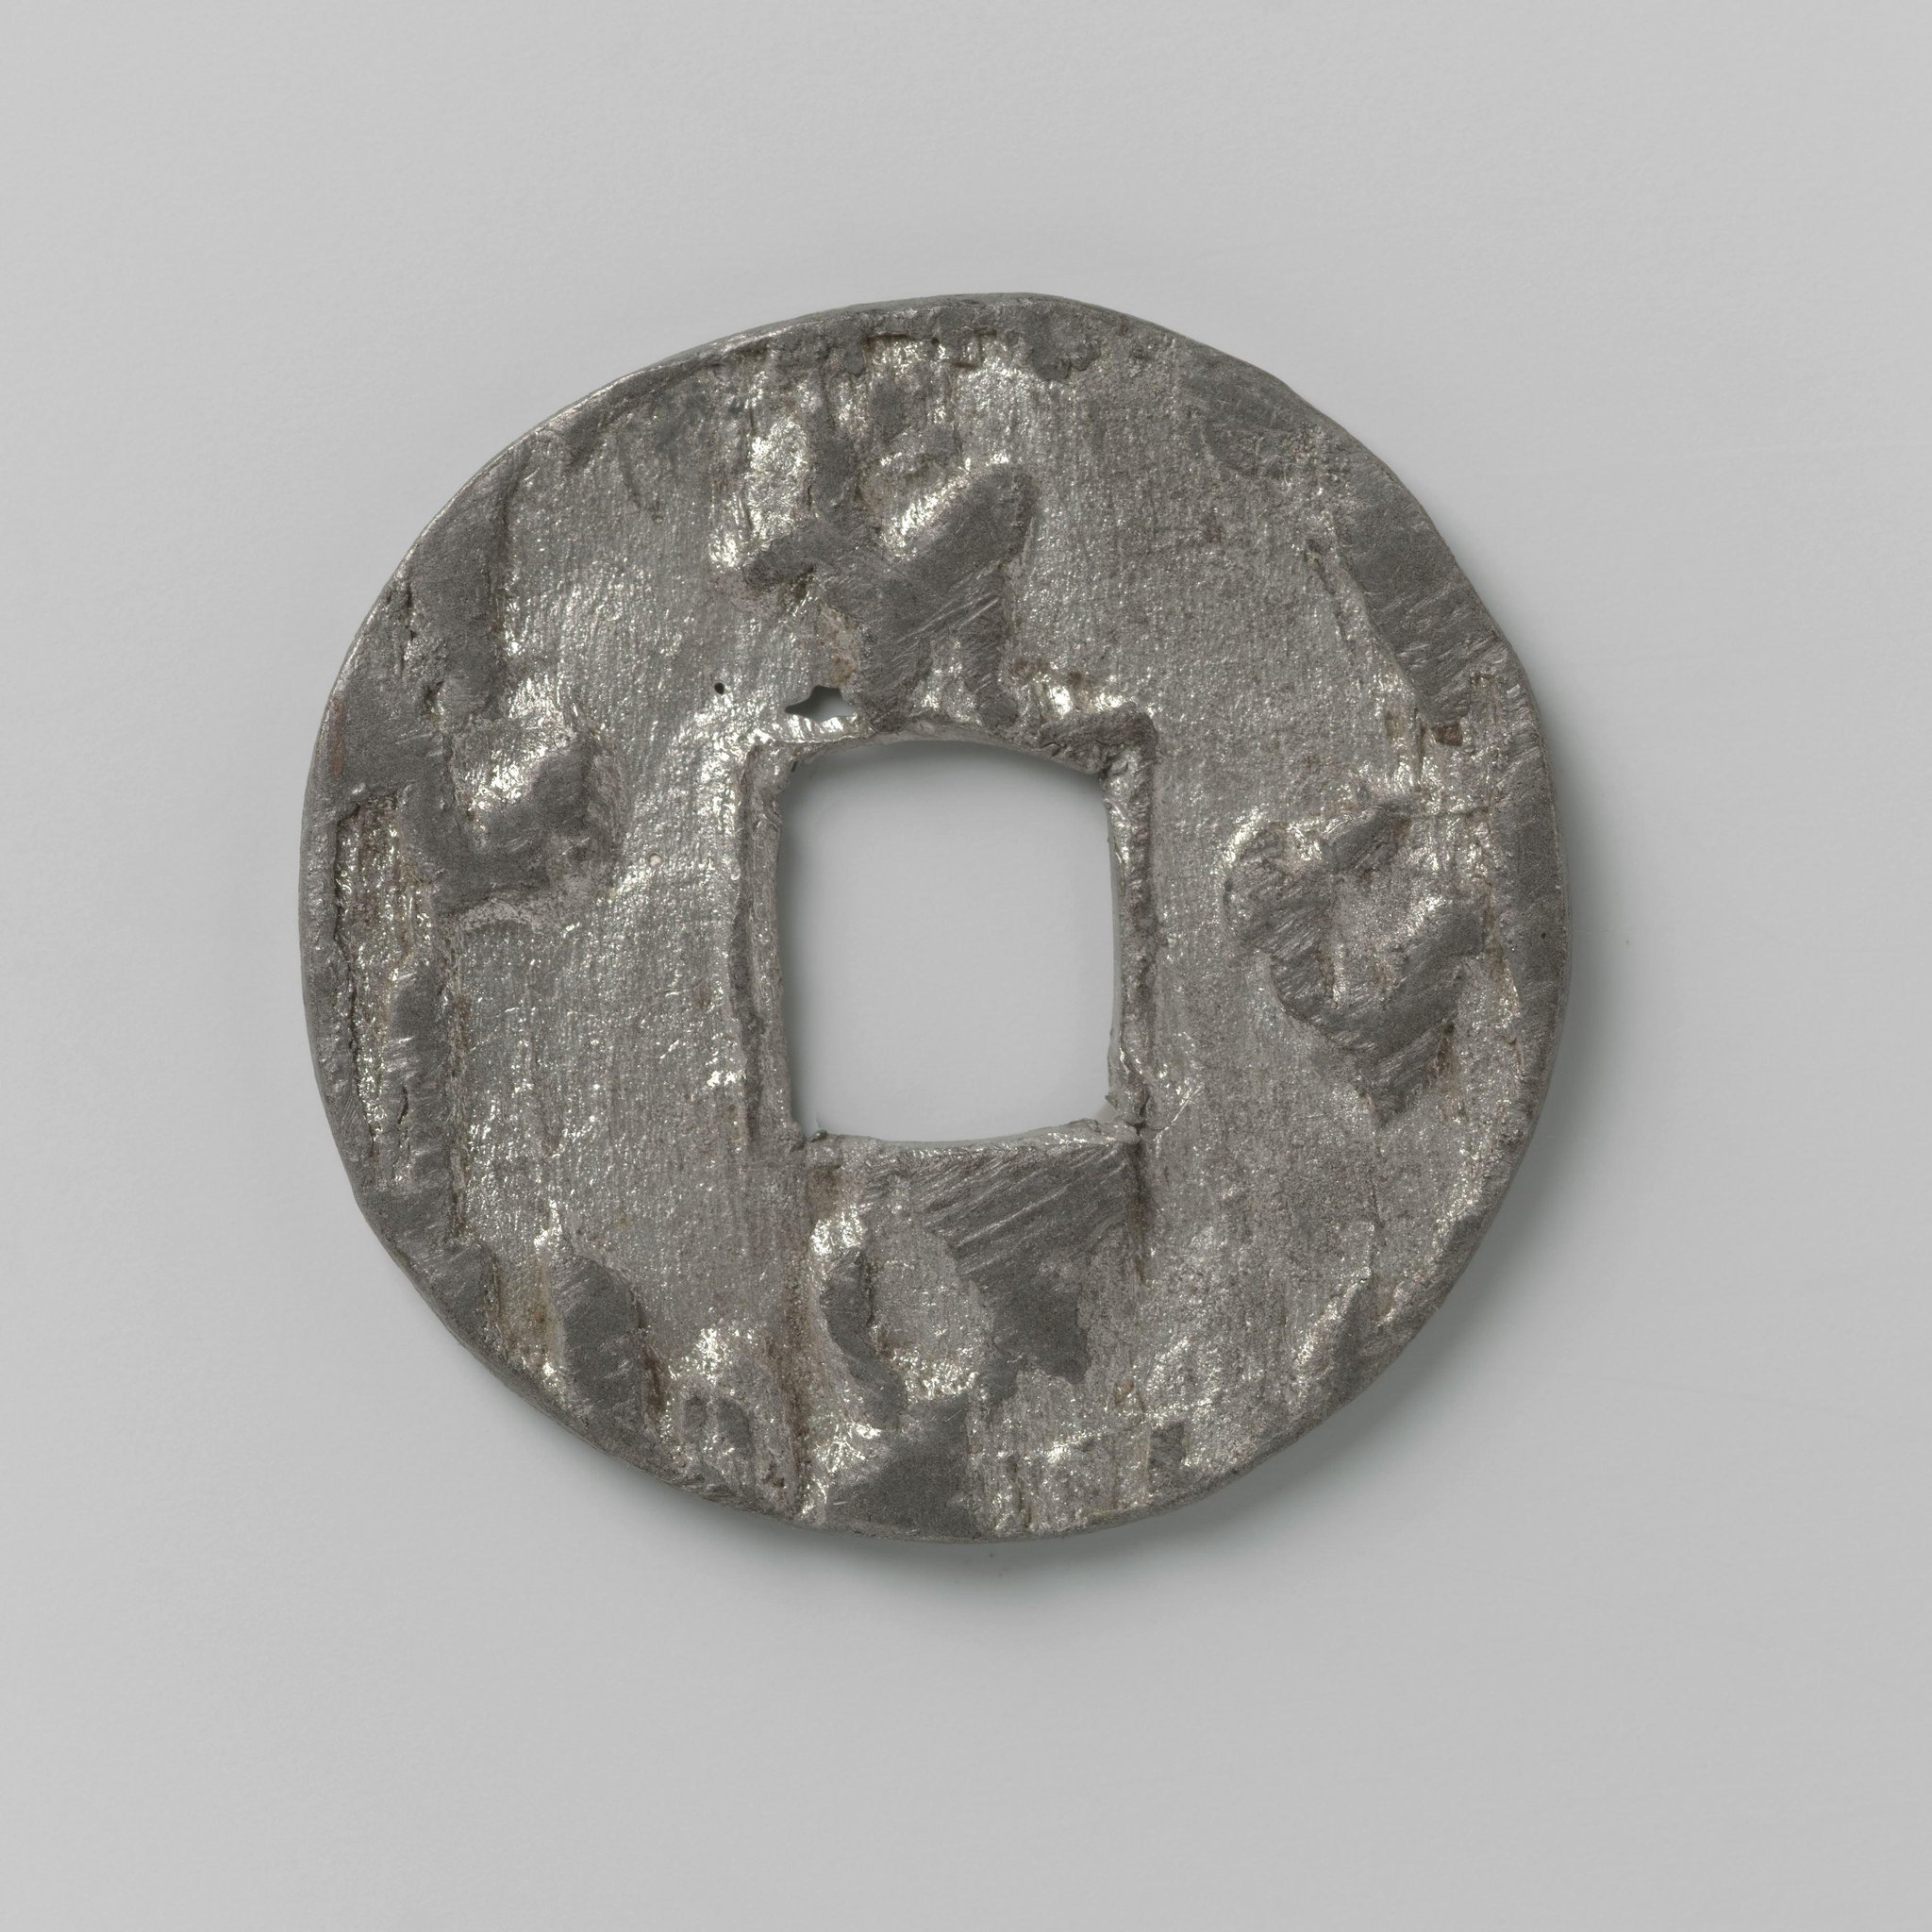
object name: coin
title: Keteng van Soerakarta, Java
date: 1700-1800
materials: tin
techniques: casting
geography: soerakarta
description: Tinnen munt. Voorzijde: vier karakters. Keerzijde, glad. In het midden vierkant gat.